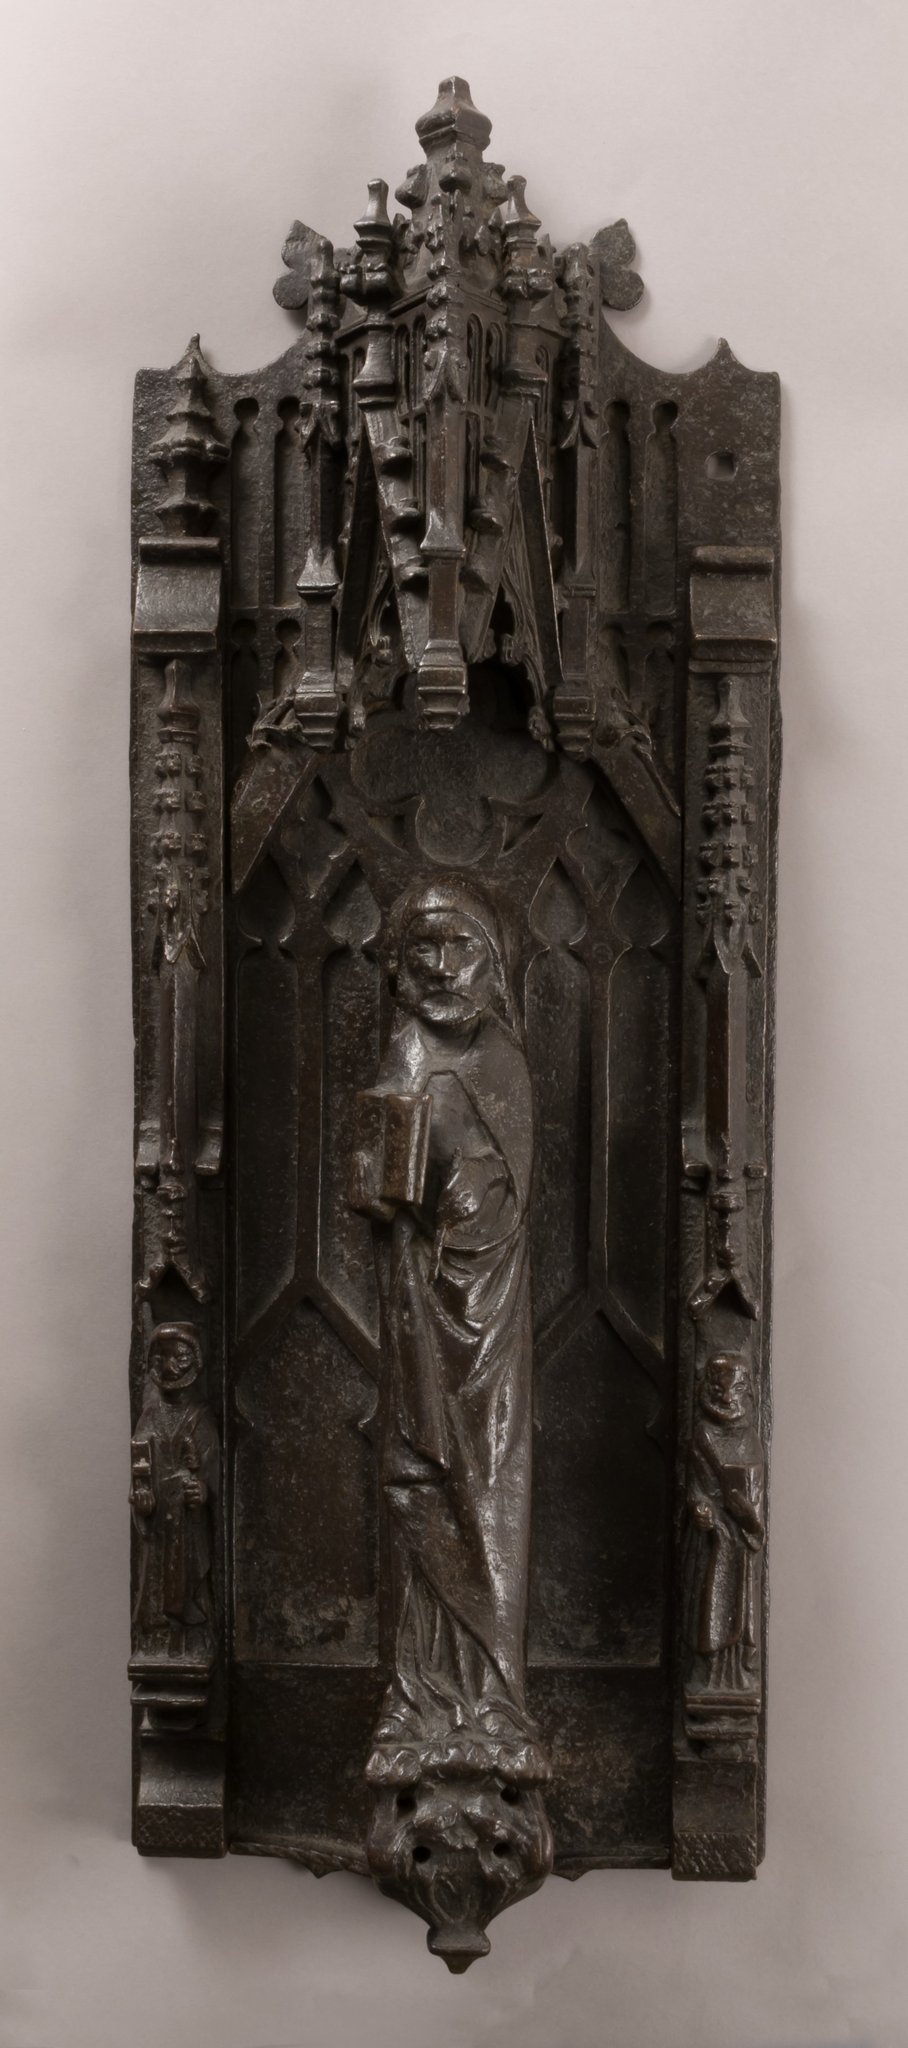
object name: door knocker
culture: european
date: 1401-1600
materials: iron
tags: men